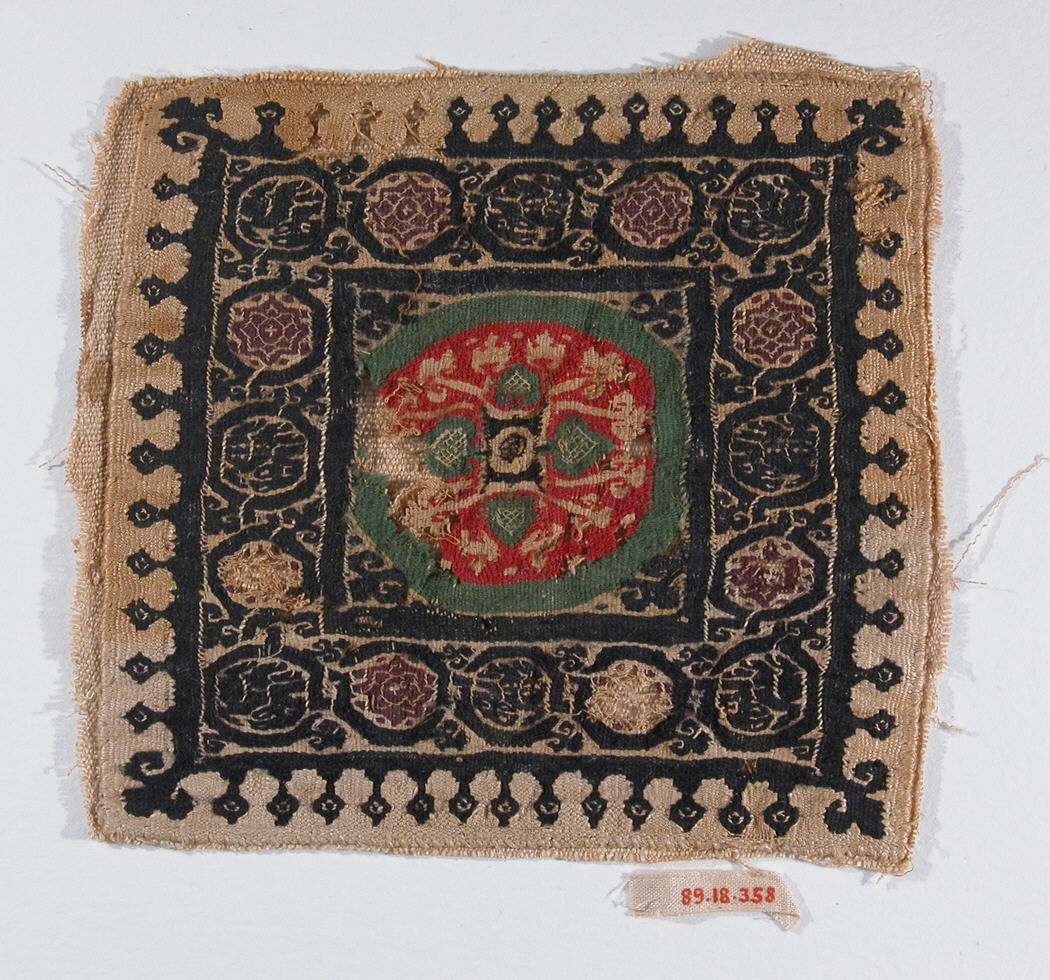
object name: textile fragment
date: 301-400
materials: linen, wool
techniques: weave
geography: egypt